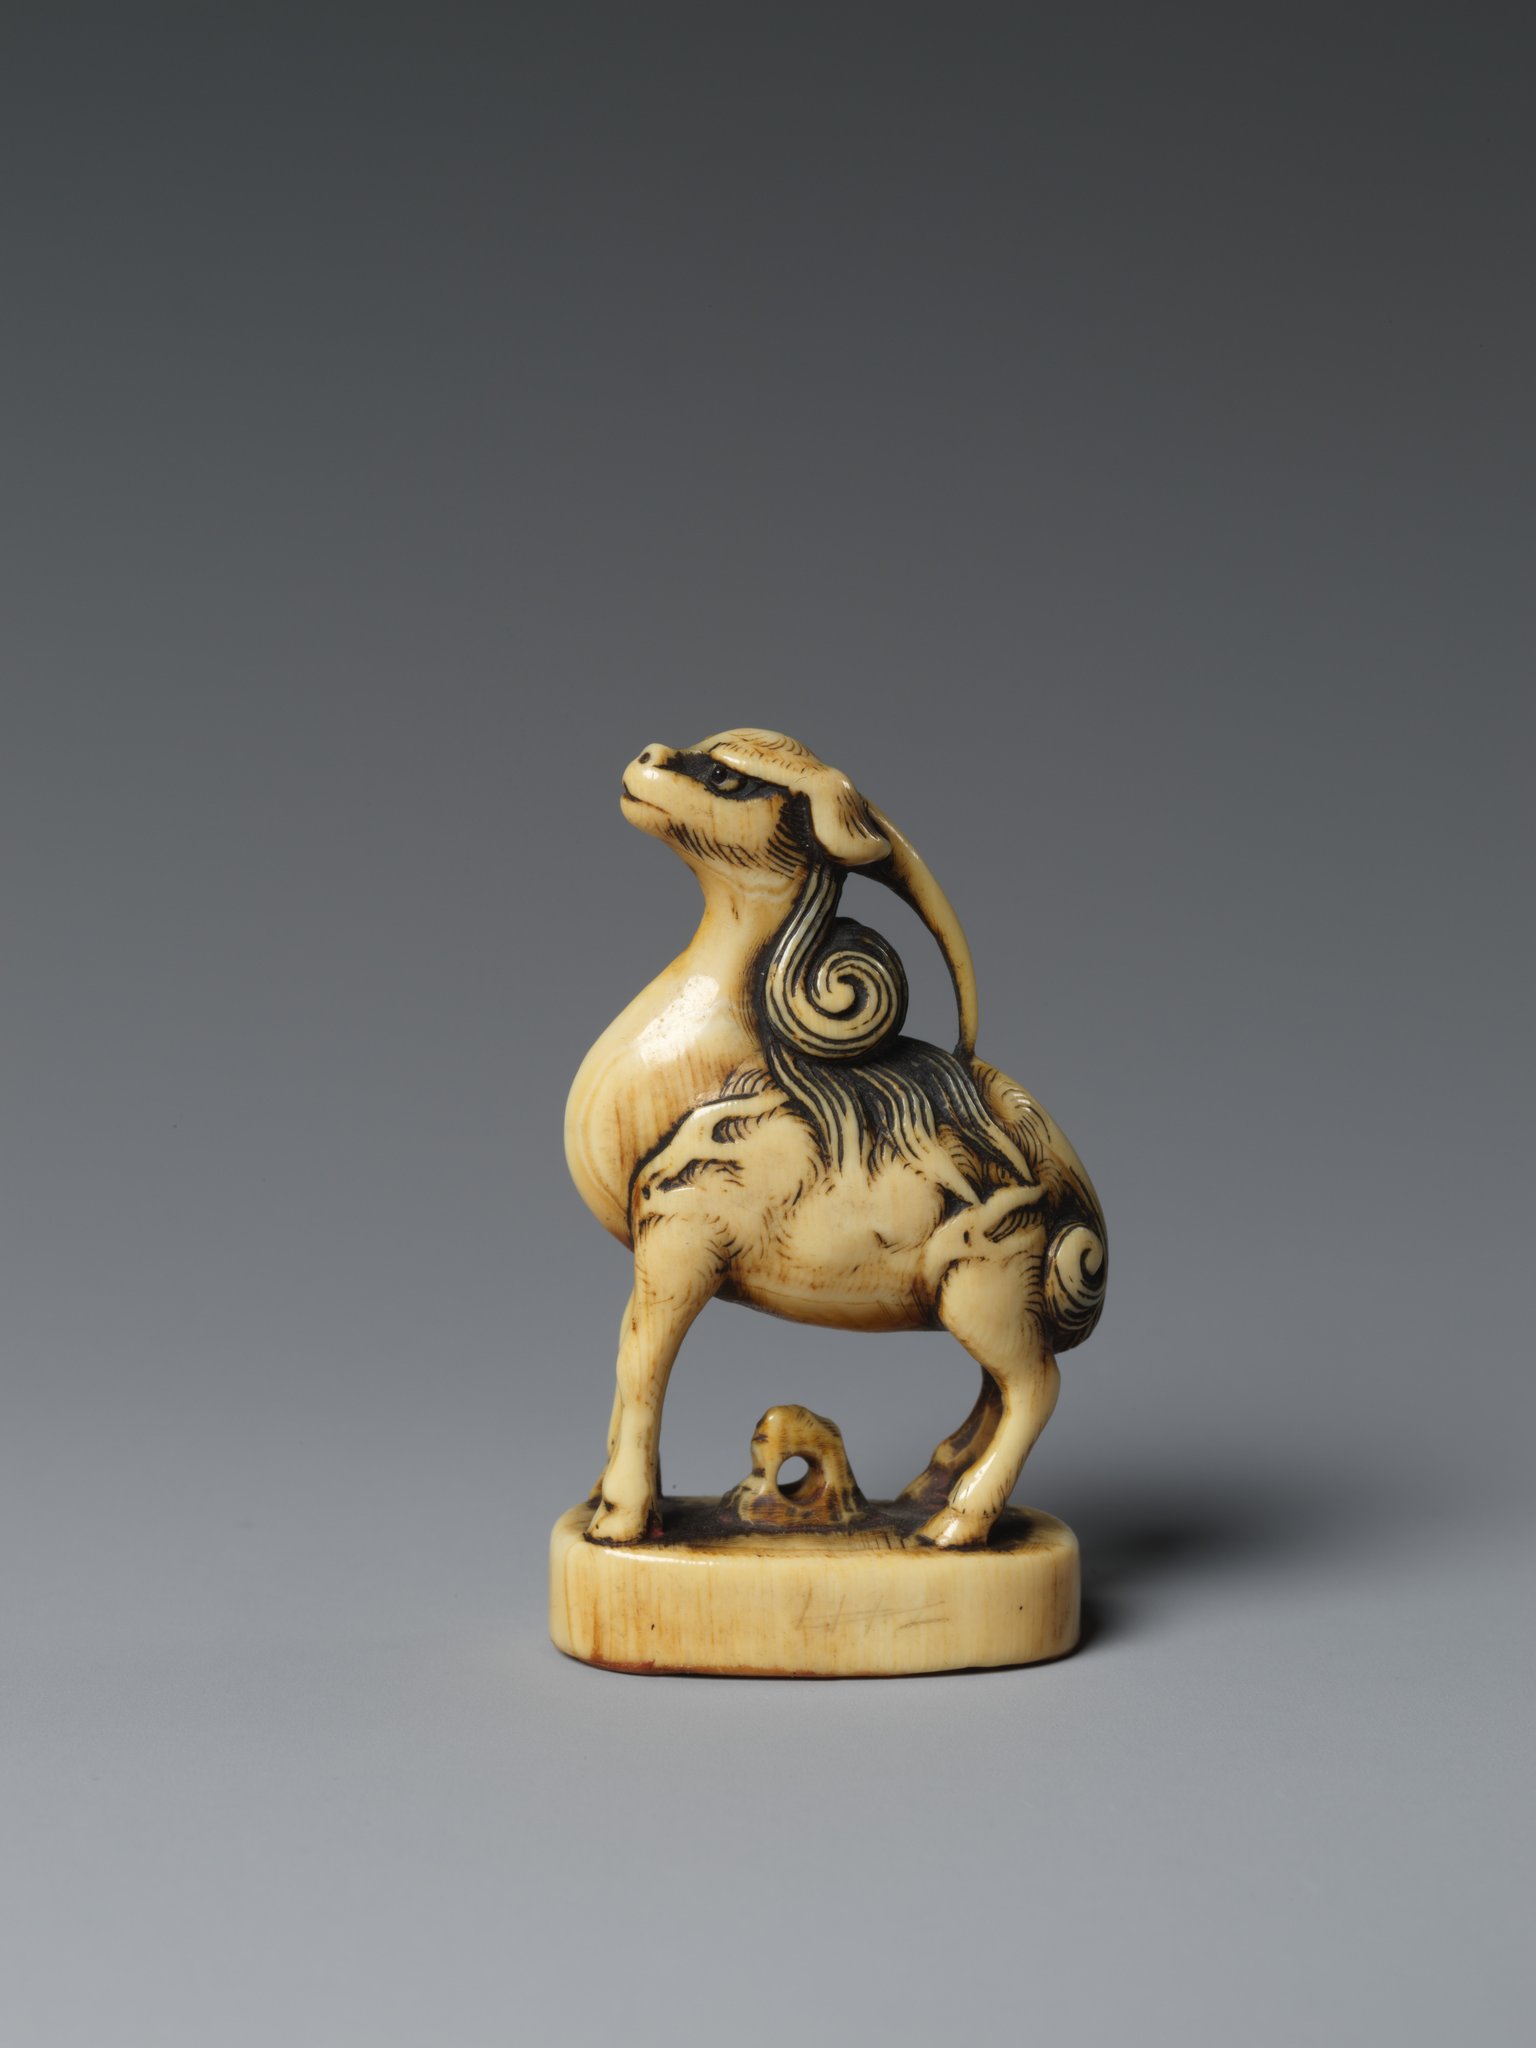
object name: netsuke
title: Mythical Chimera (Kirin) Standing on a Seal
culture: japanese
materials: ivory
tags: mythical creatures